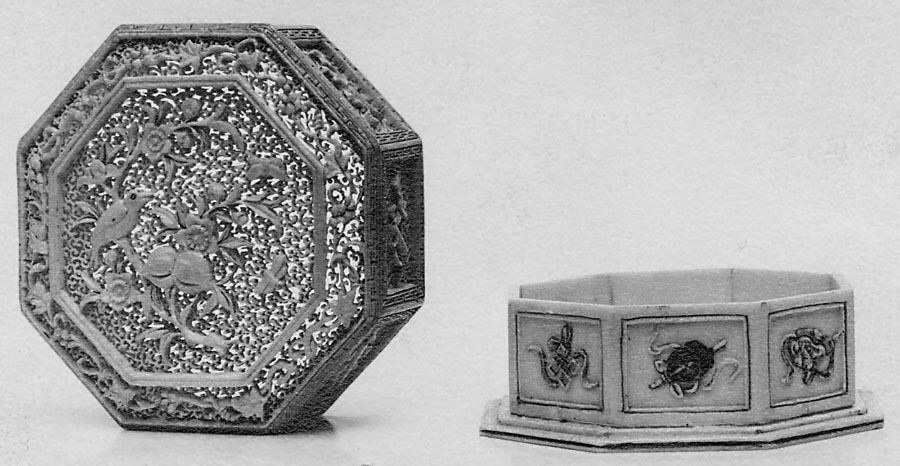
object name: box with cover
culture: chinese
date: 1801-1900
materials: ivory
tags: flowers